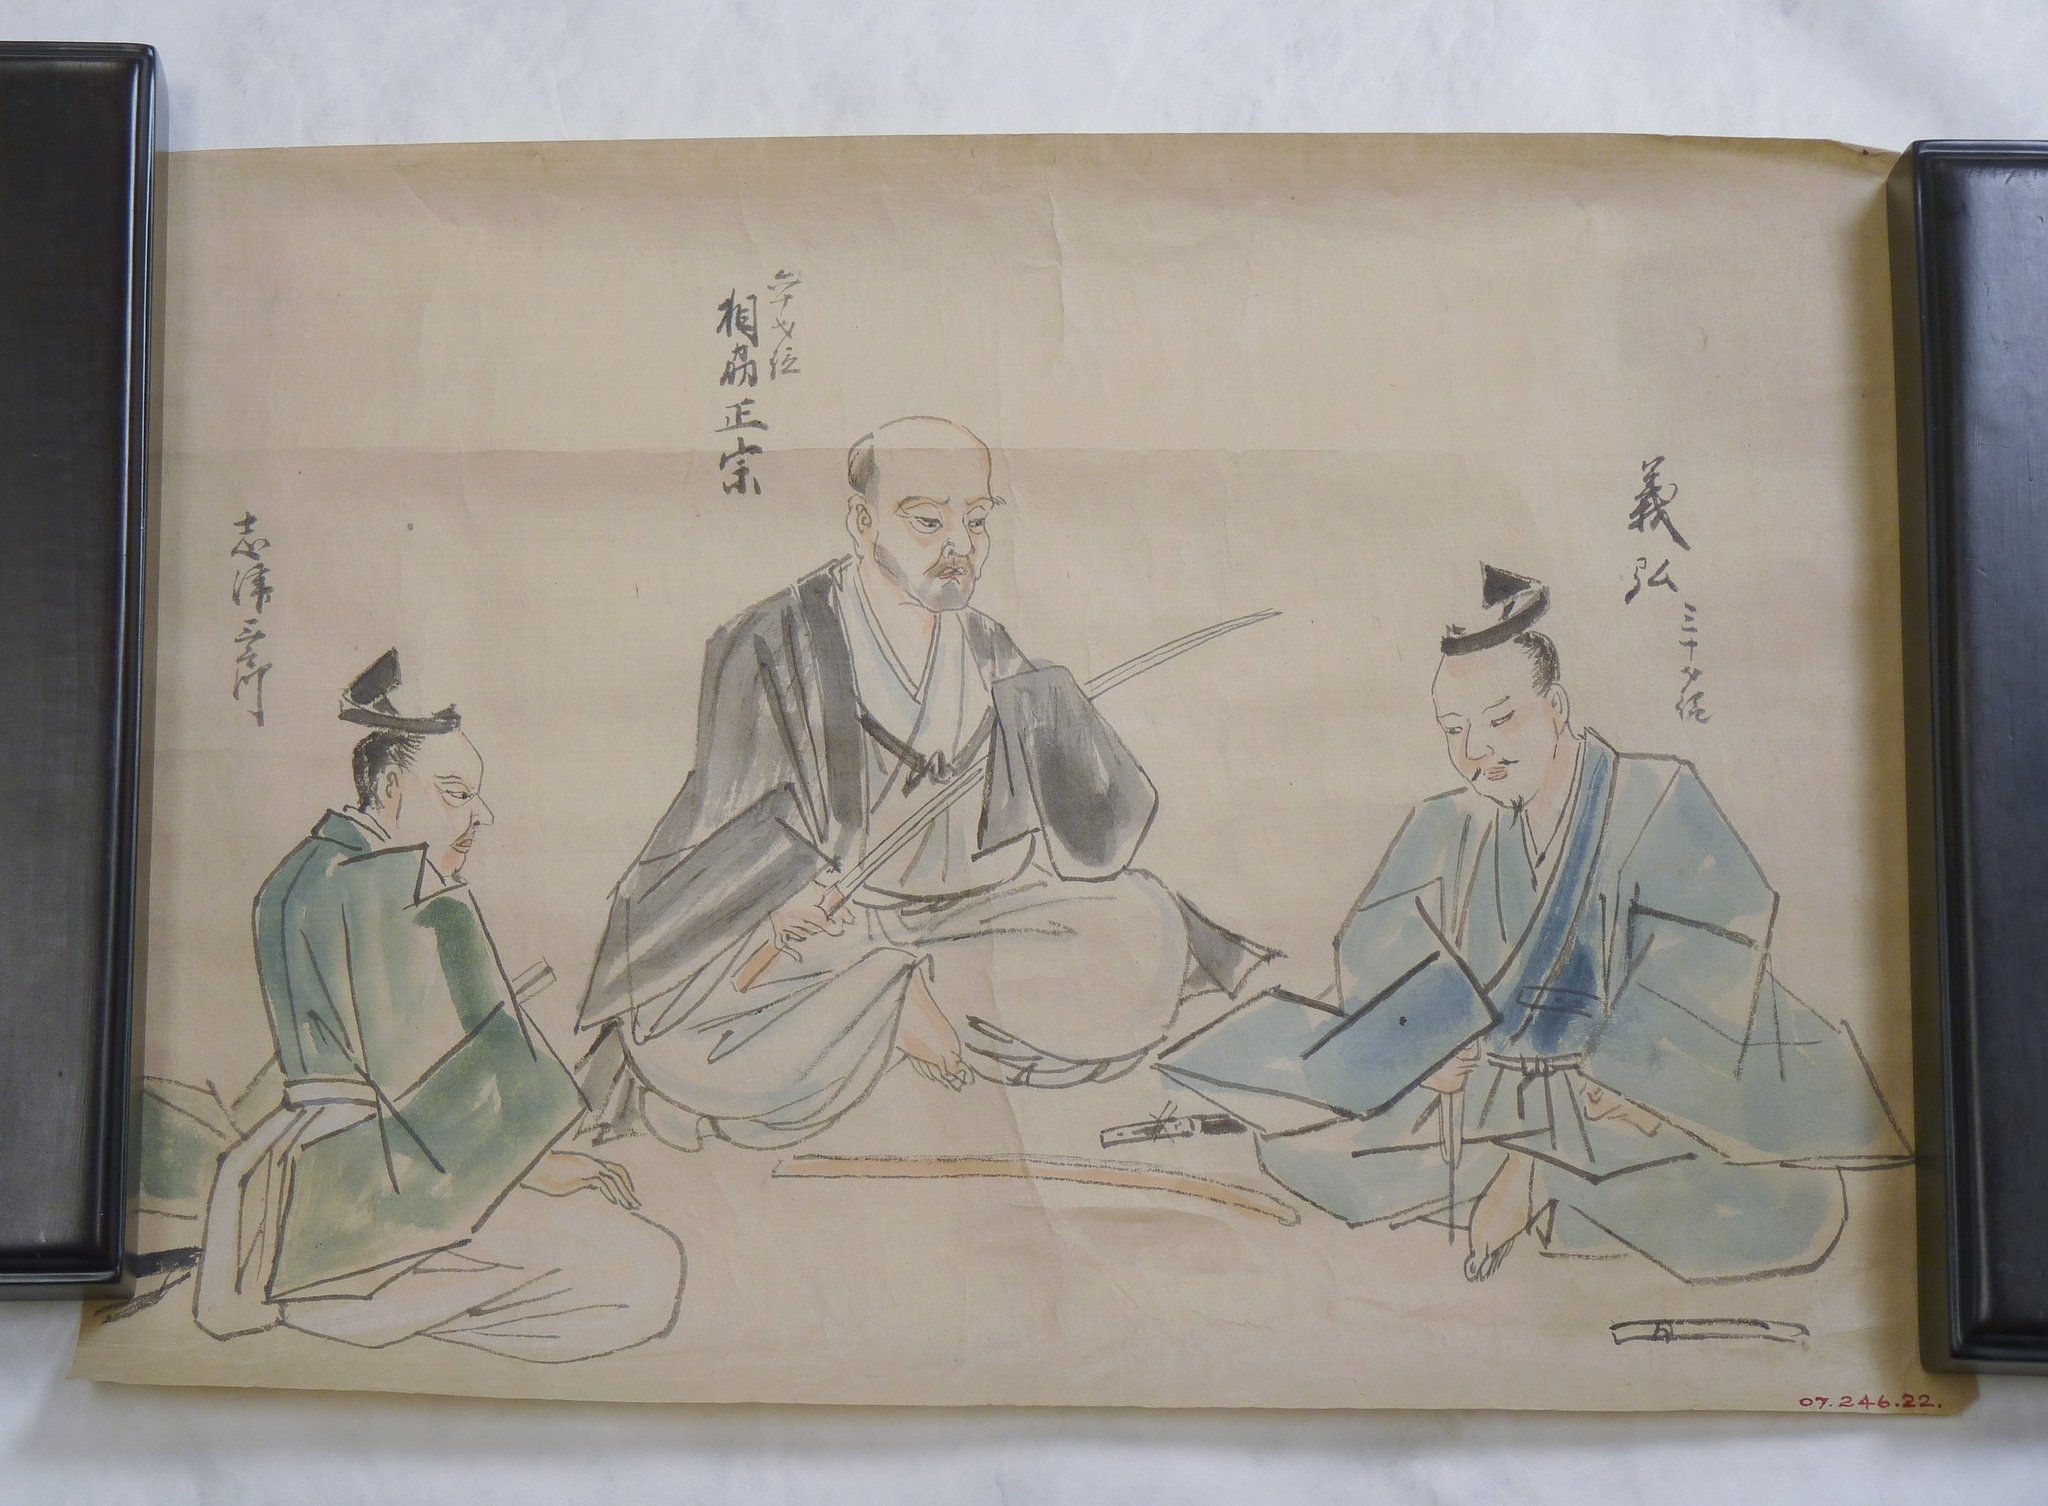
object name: drawing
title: Japanese Drawing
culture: japanese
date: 1801-1833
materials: paper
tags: men